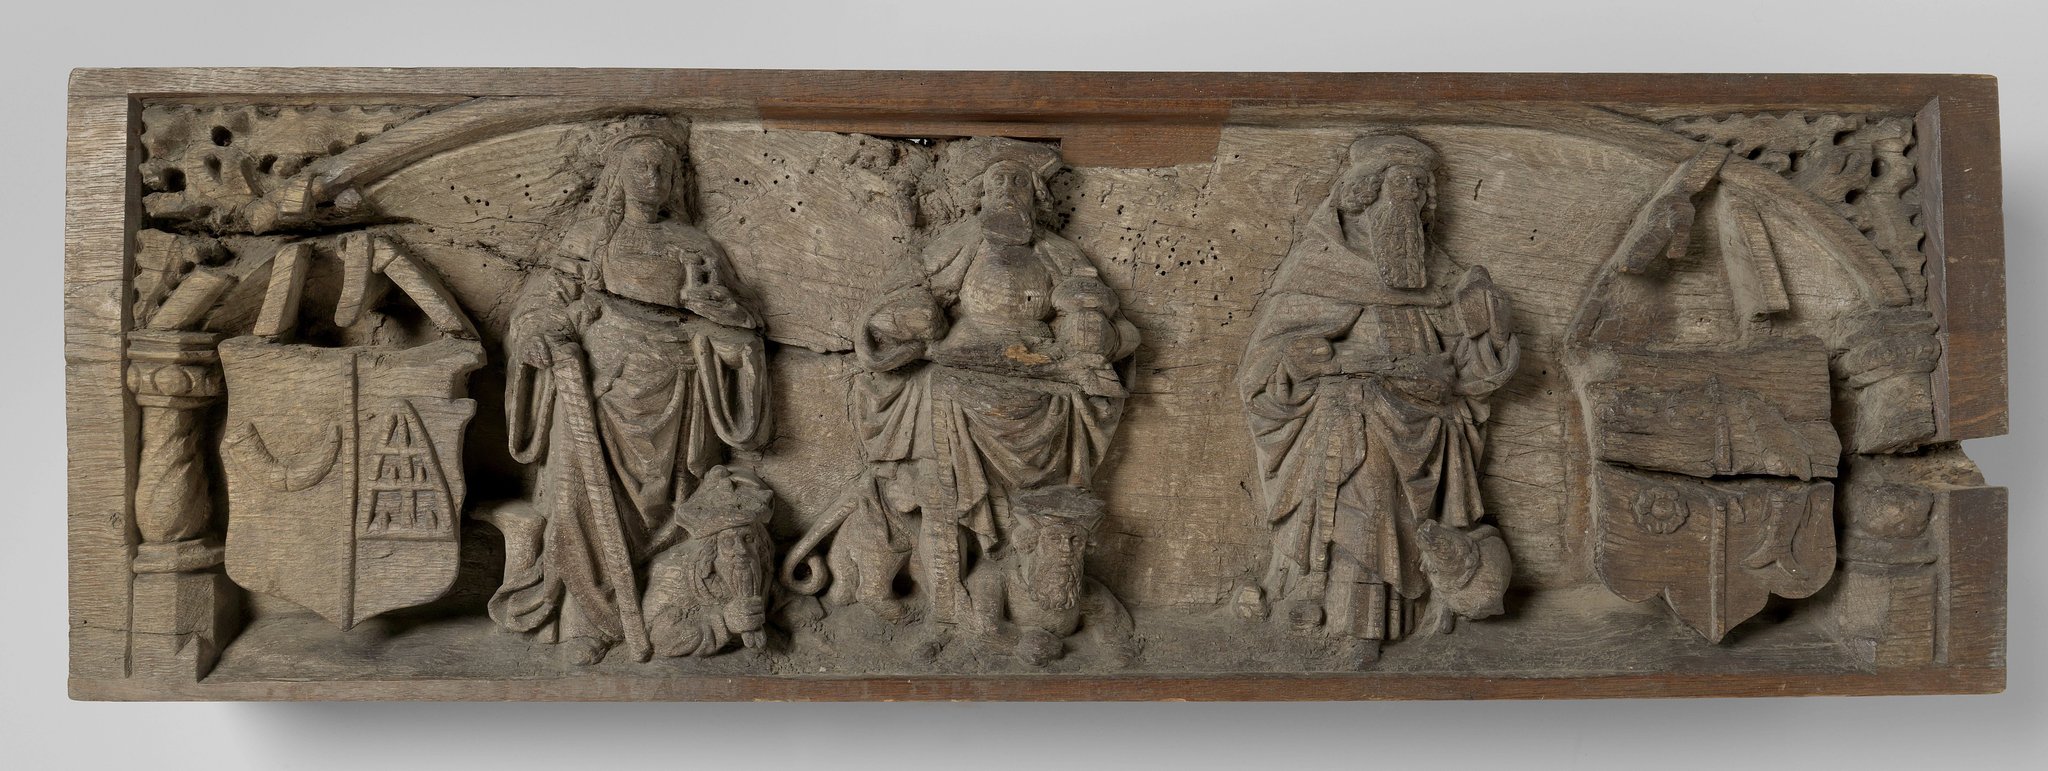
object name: deurkalf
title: Lintel with Sts Catherine or Barbara, Olaf and Anthony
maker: Anonymous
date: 1500-1525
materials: wood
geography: guelders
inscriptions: coat of arms, at the right, in relief: parted per pale, 1. three roses; 2. a fish, crowned and vertically aligned, coat of arms, at the left, in relief: parted per pale, 1. a hunting horn; 2. a triangular harrow